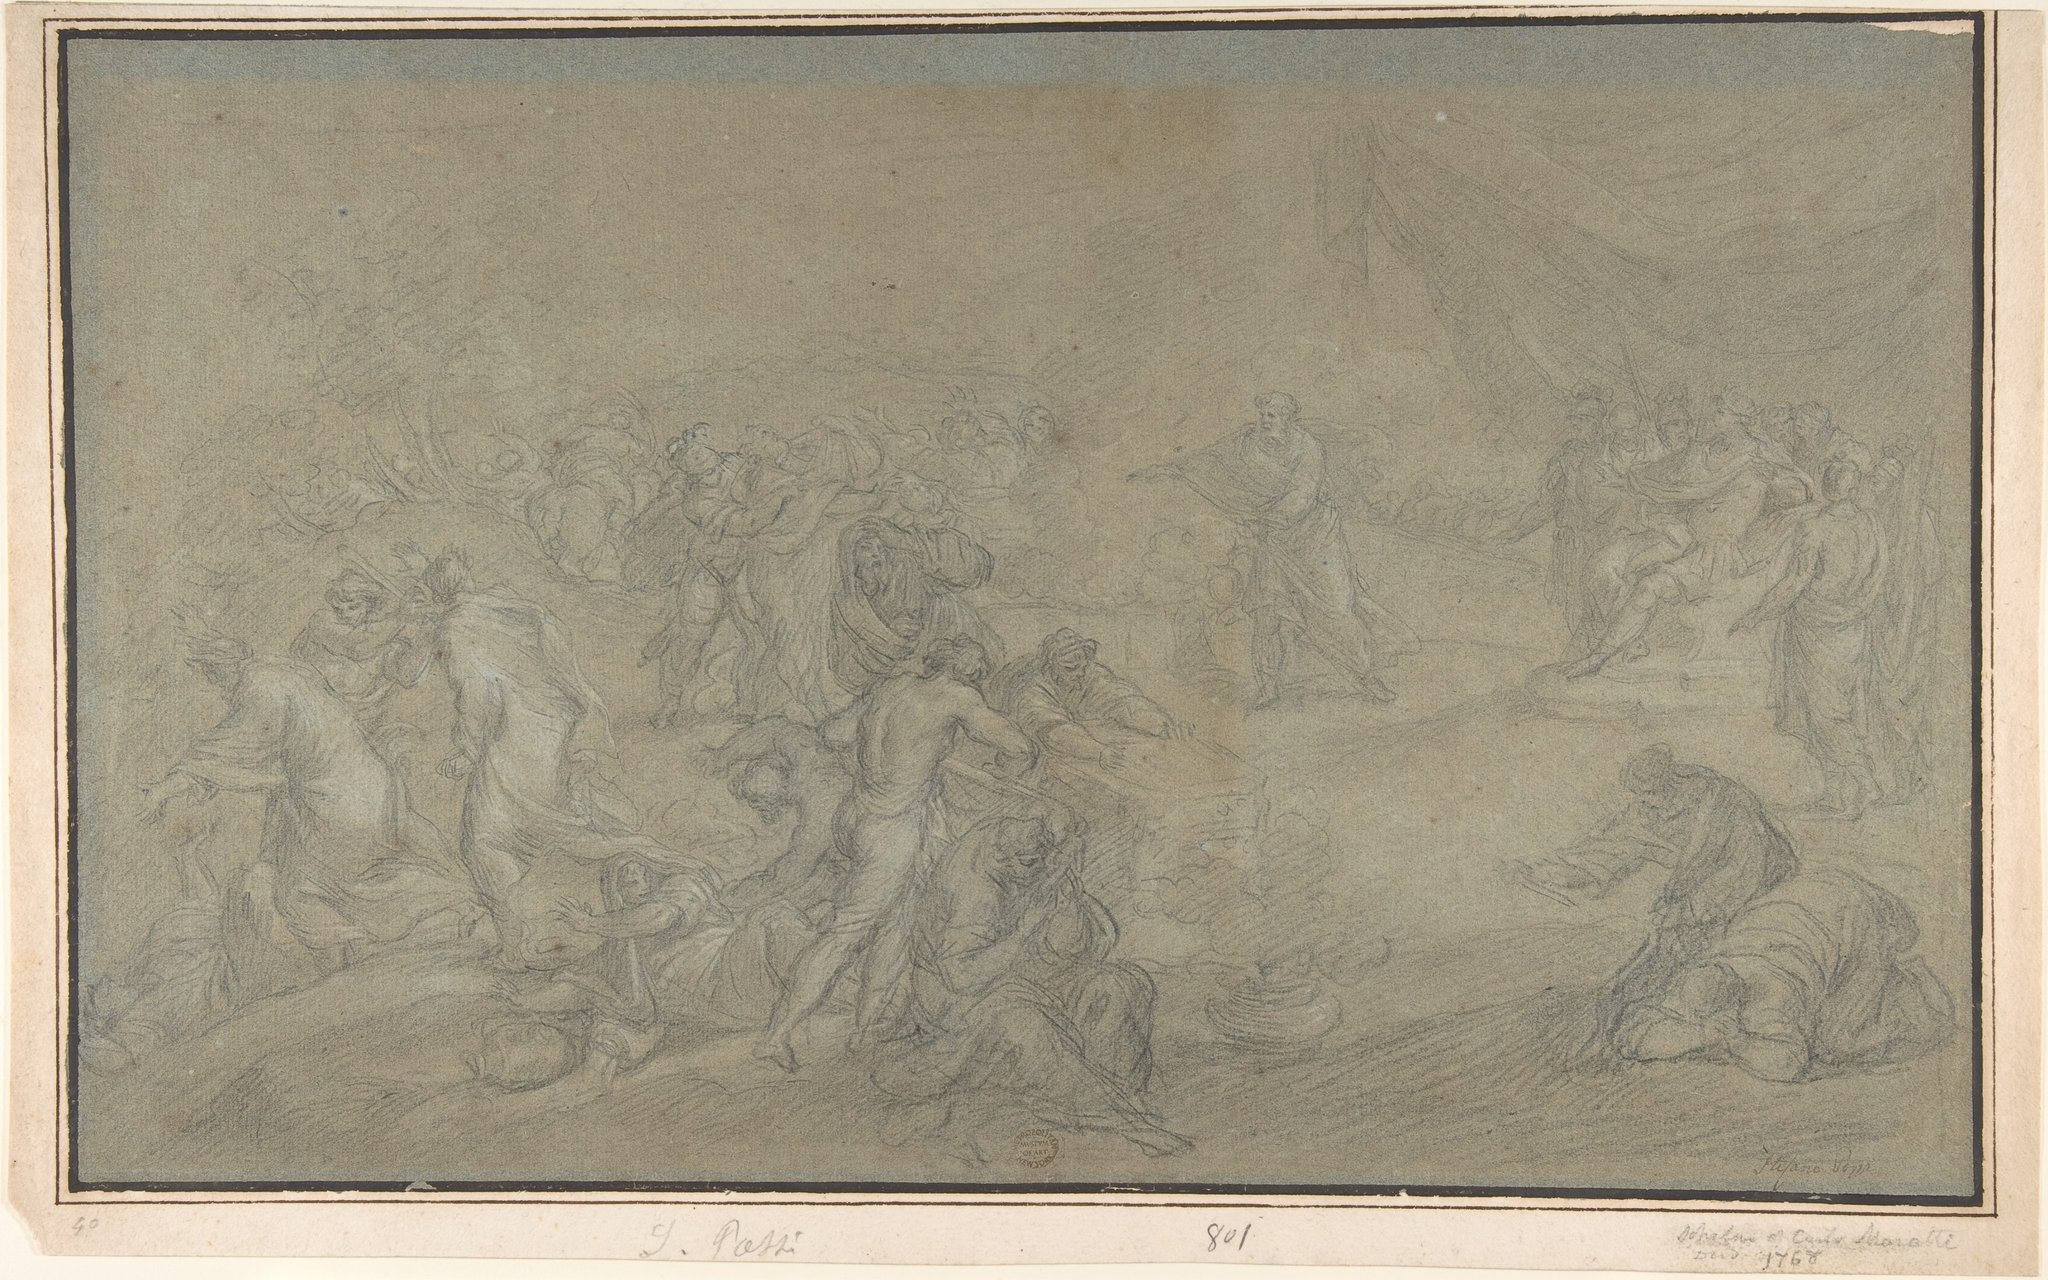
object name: drawing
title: The Contest of Elijah and the Prophets of Baal on Mount Carmel (I Kings 18: 20-46)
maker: stefano pozzi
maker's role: artist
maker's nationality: italian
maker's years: 1699-1768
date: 1720-1768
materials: chalk, paper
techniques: highlighting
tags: men,crowd